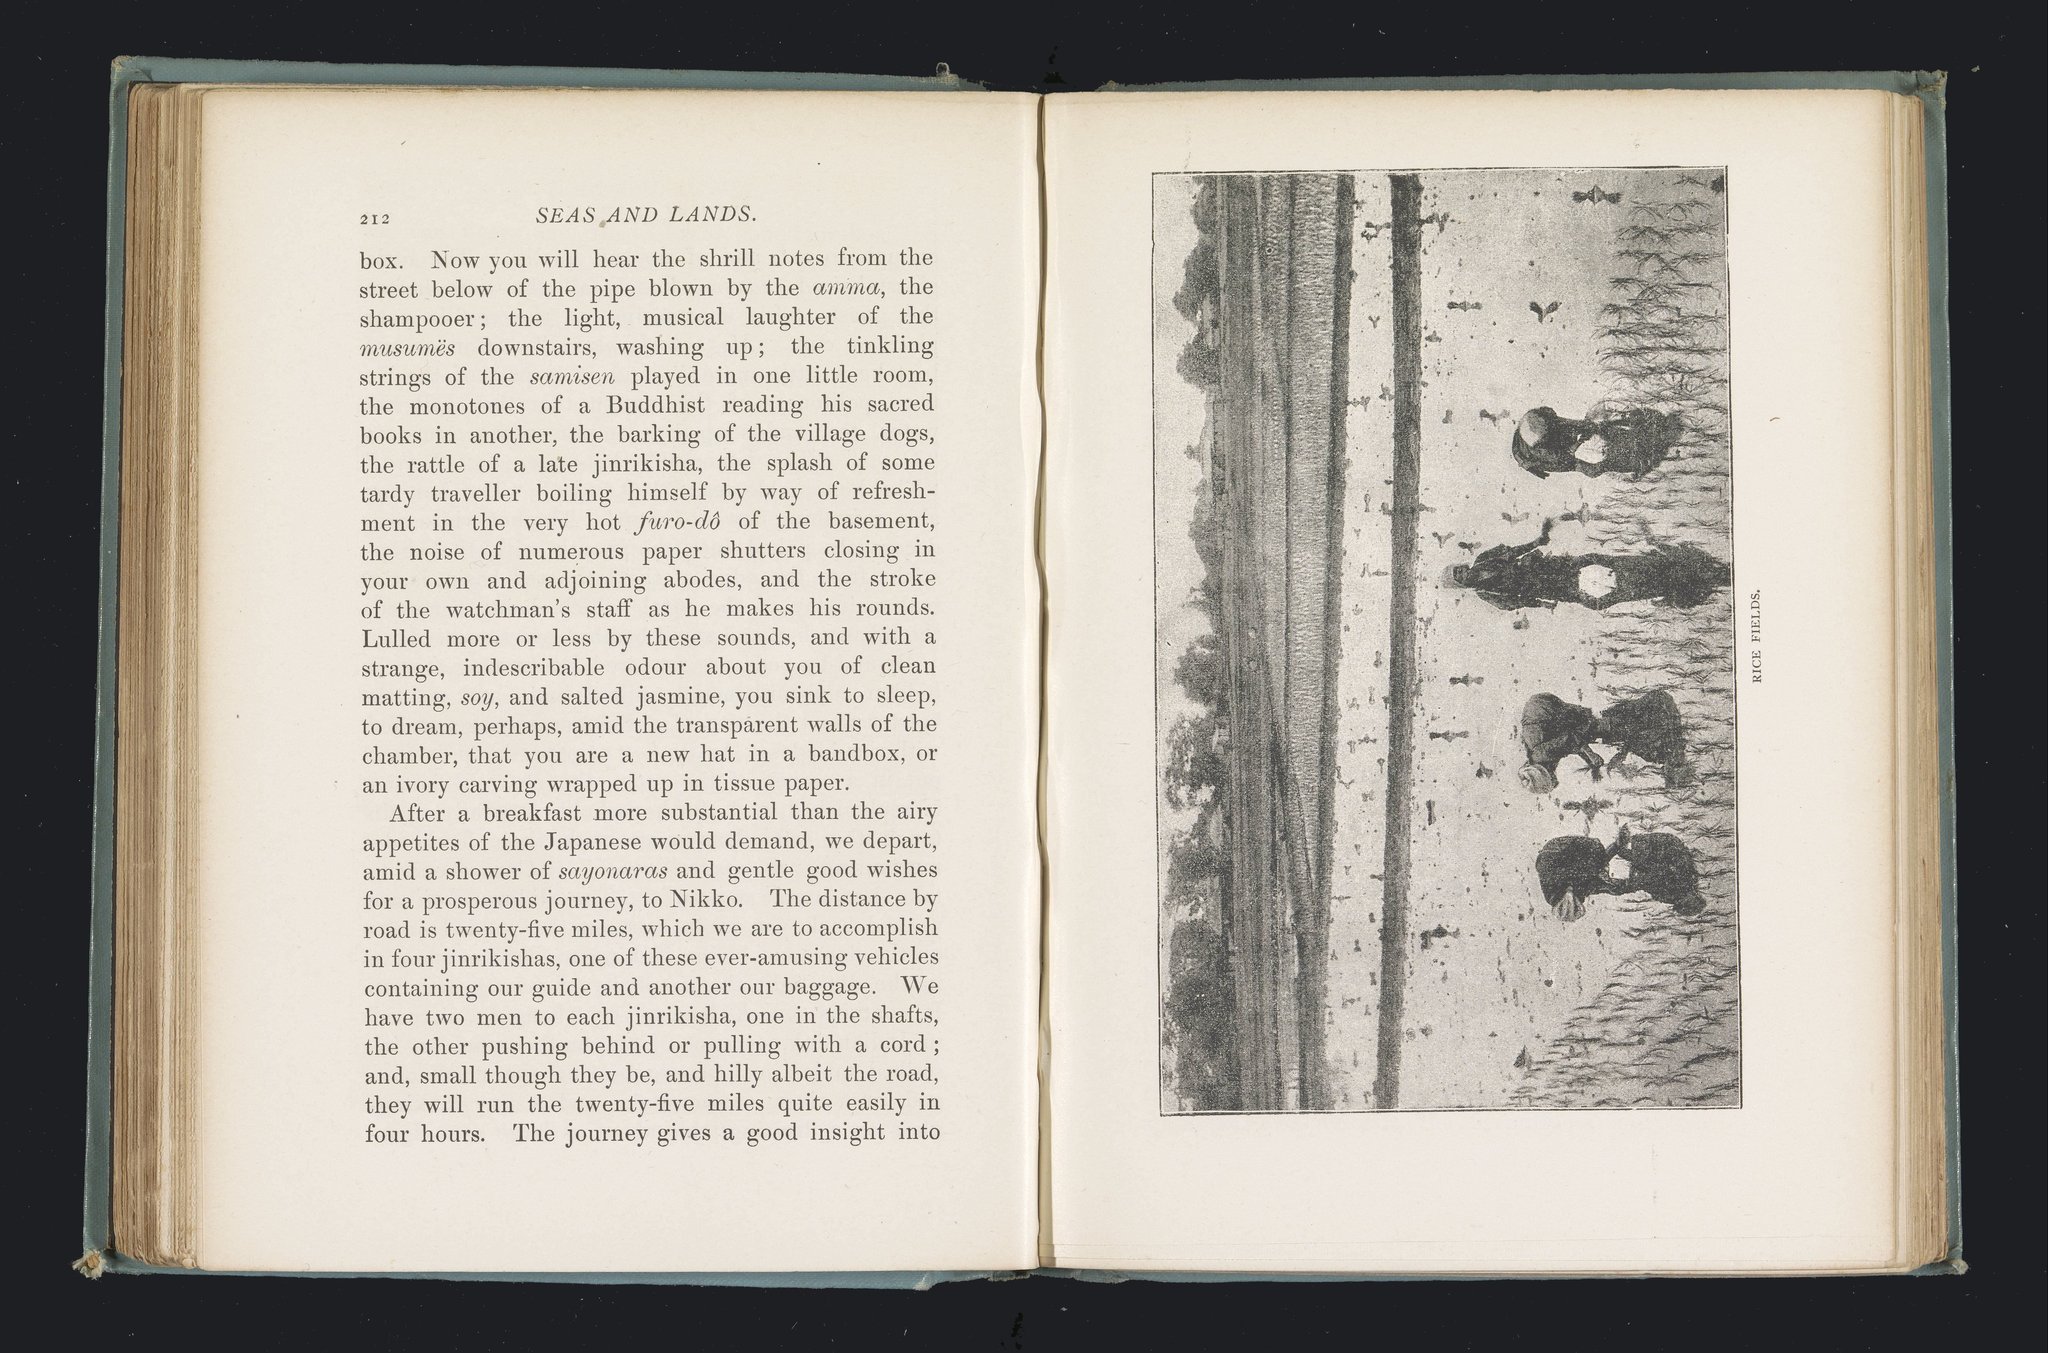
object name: photomechanical print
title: Rice fields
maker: Anonymous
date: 1882-1892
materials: paper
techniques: autotype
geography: japan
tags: sawahs, rice paddies